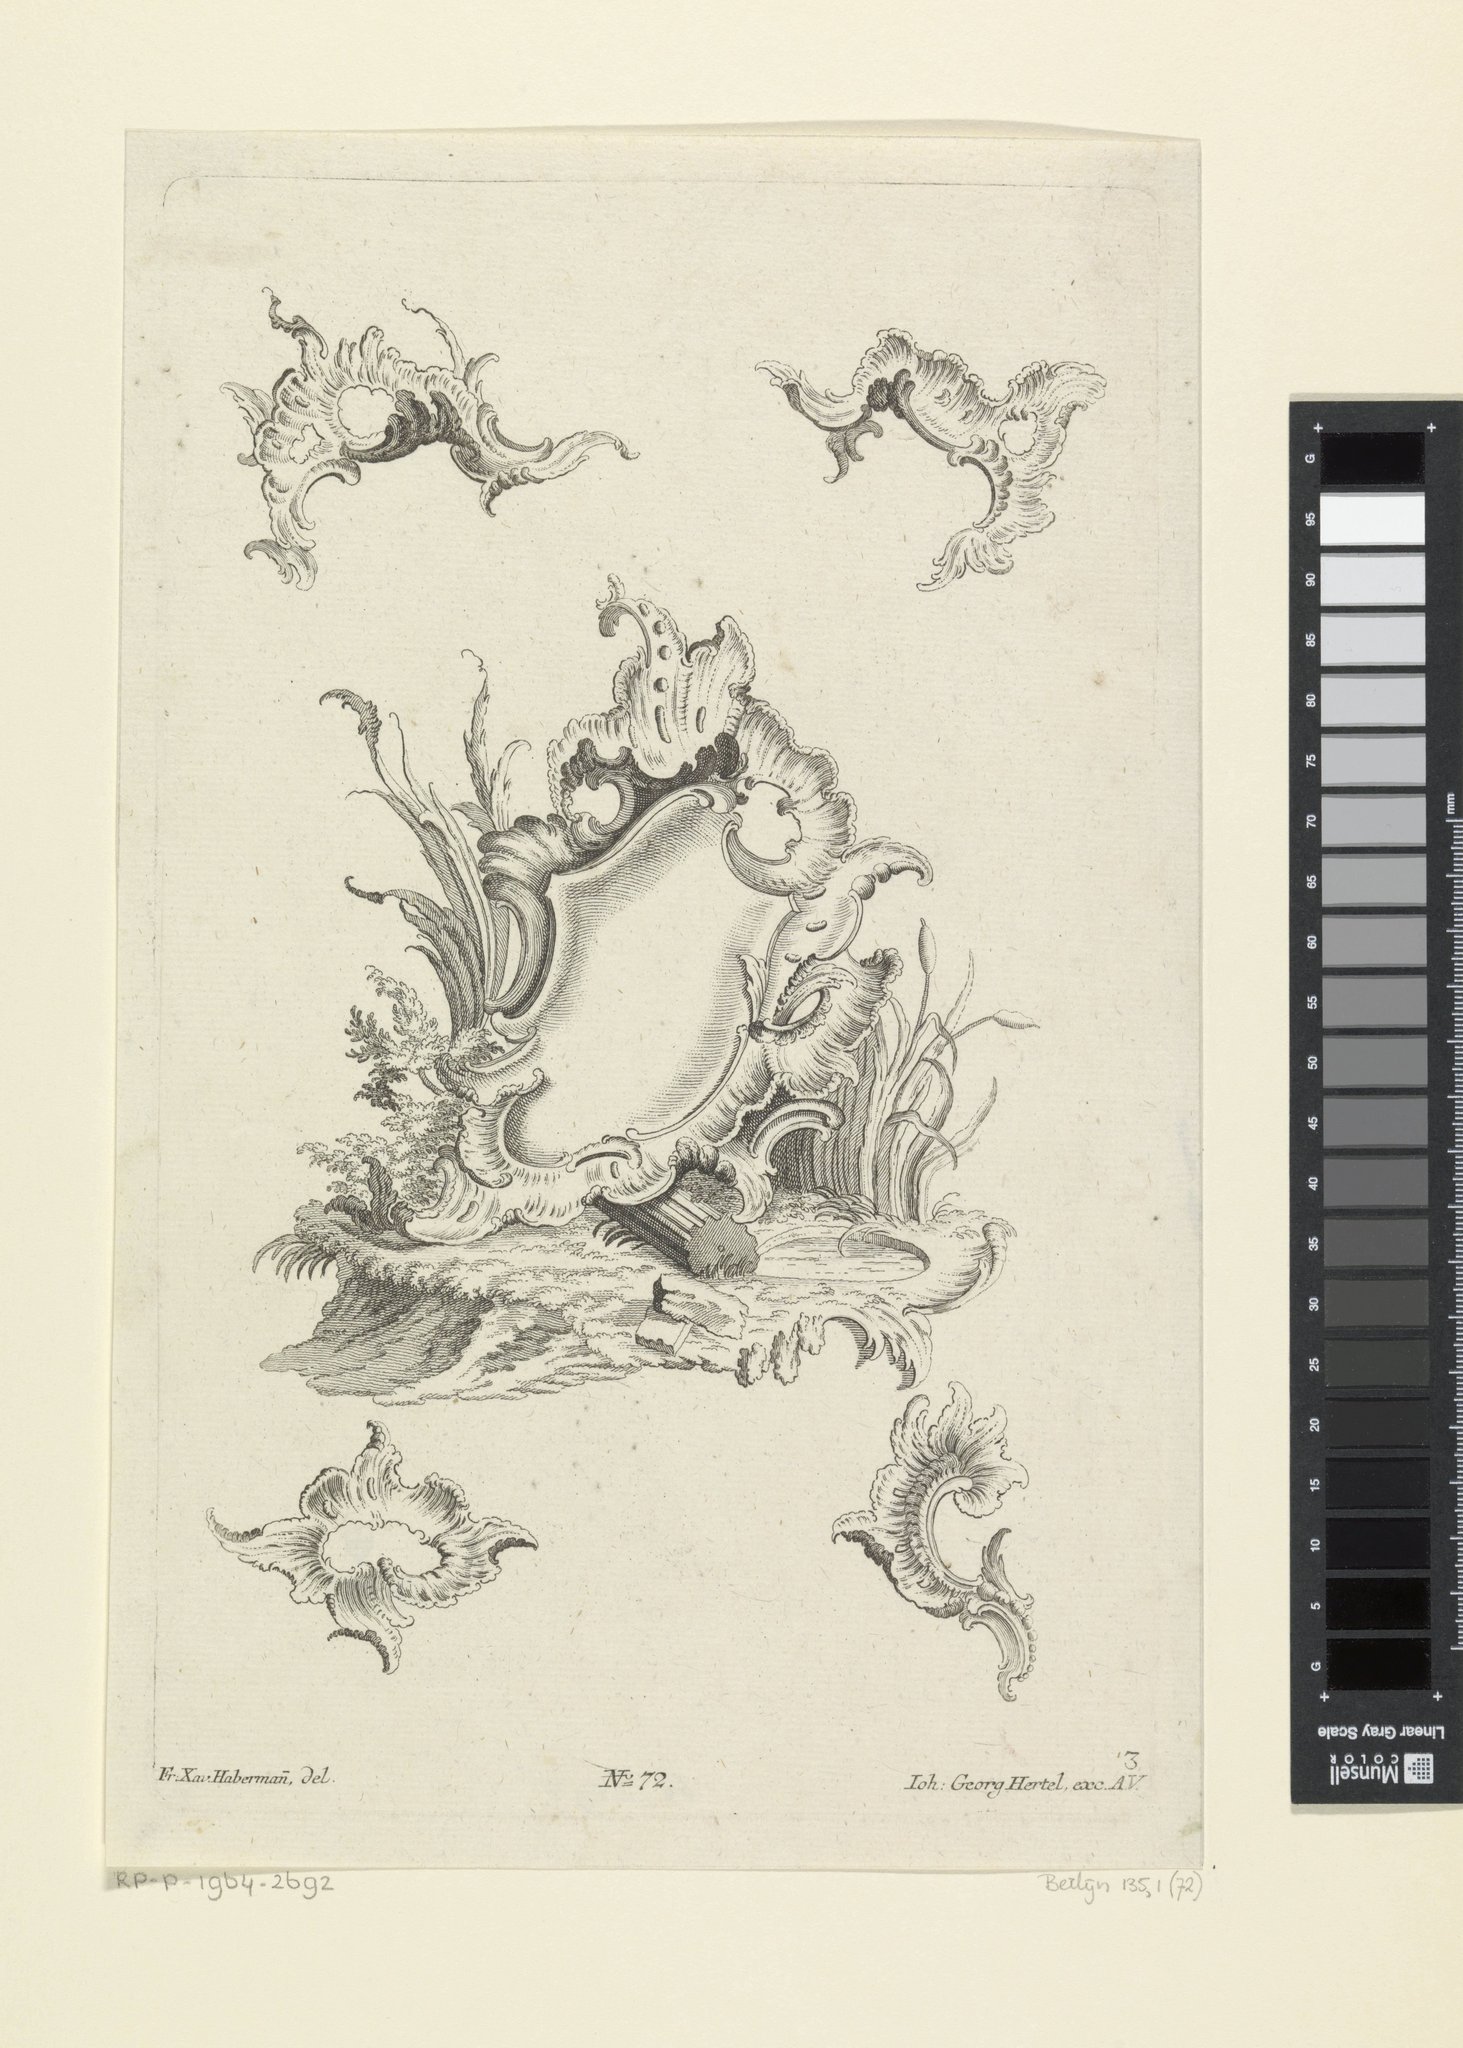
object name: ornament print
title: Cartouche met pilaar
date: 1731-1775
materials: paper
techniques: etching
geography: augsburg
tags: rocaille ornament, ornament ~ cartouche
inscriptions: collector's mark: Lugt 2228, collector's mark: Lugt 2760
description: Vier rocaille ornamenten en een rocaille cartouche met pilaar en lisdodden in landschap. Uitgeversnummer 72.